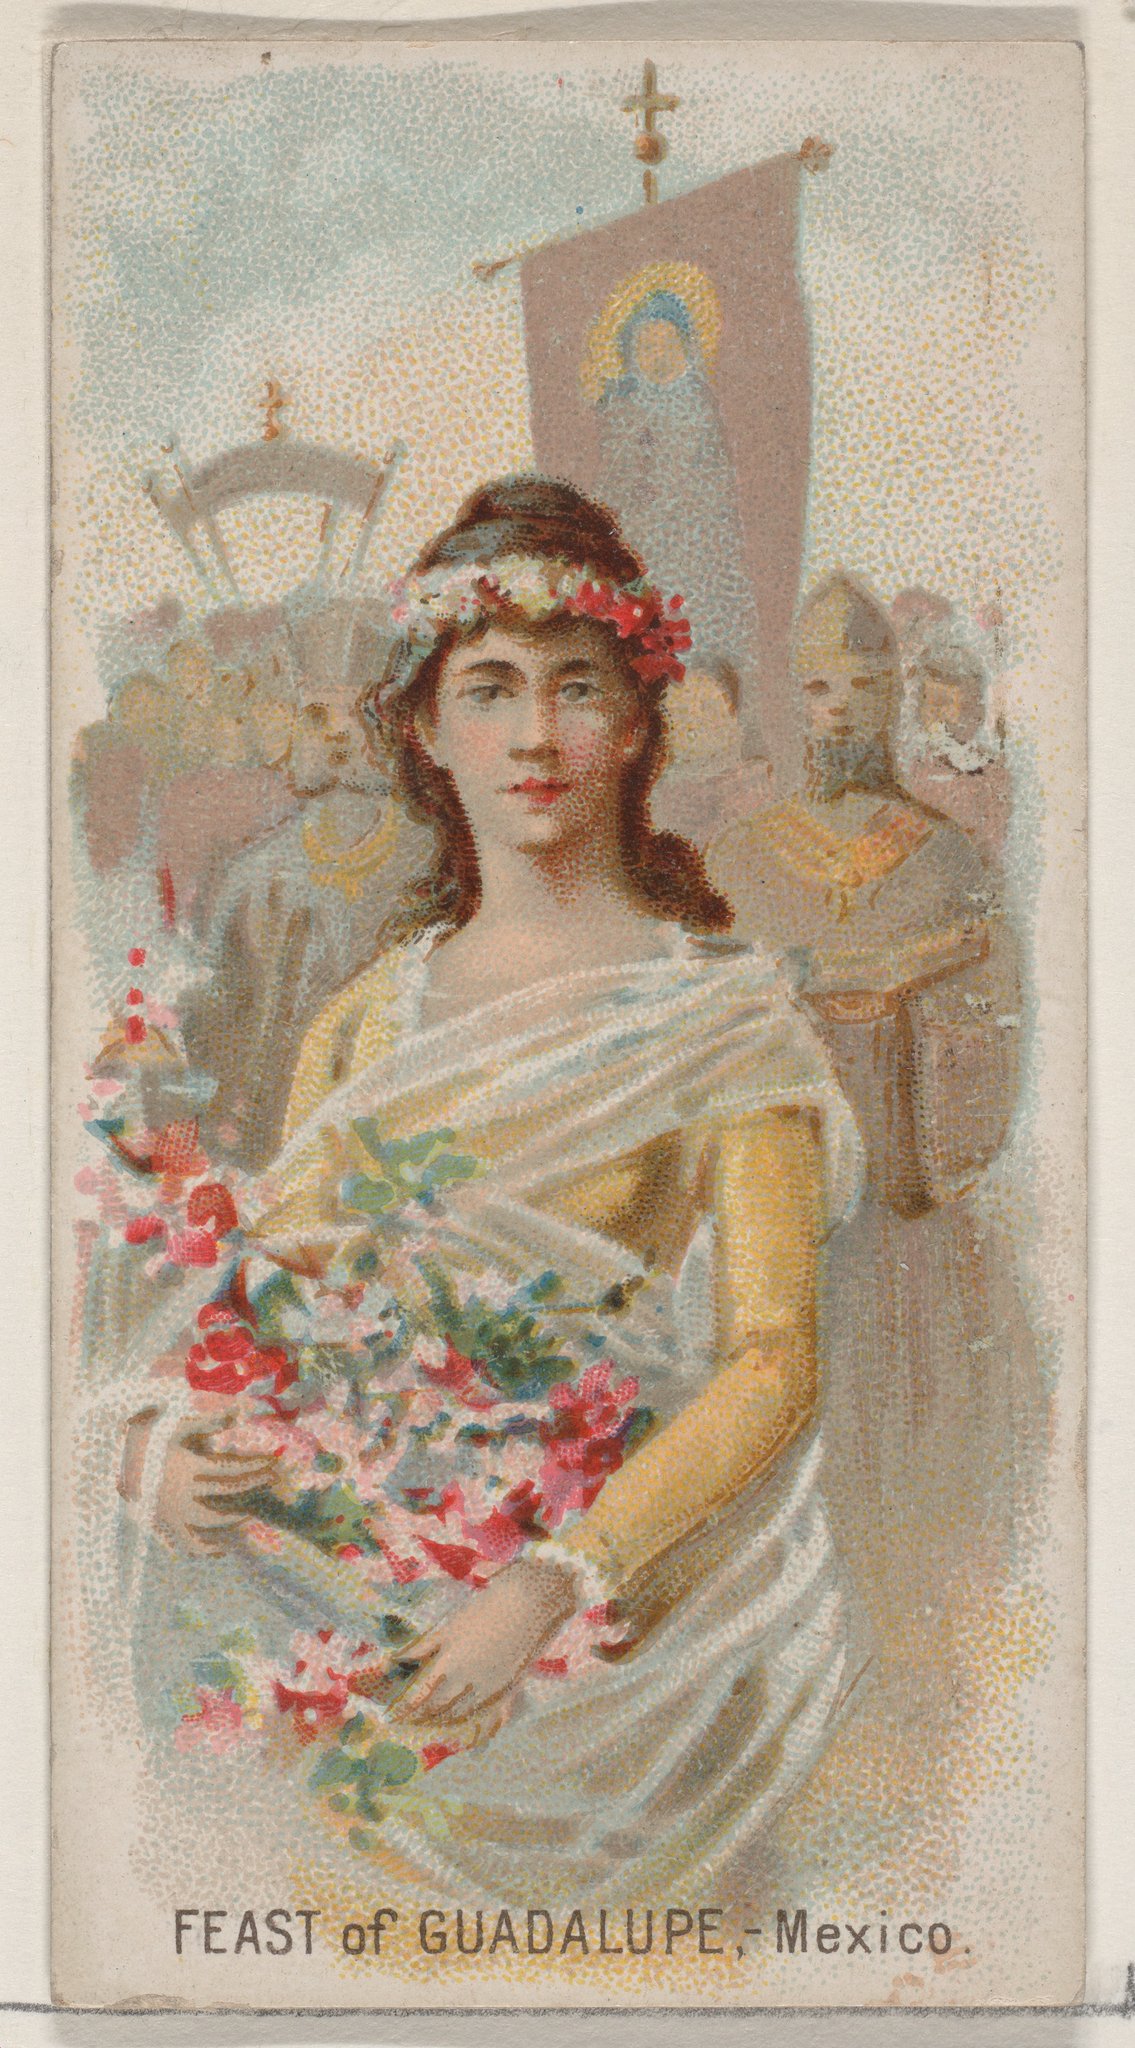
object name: print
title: Feast of Guadalupe, Mexico, from the Holidays series (N80) for Duke brand cigarettes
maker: w. duke, sons & co.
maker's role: publisher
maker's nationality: american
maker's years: 1870-1920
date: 1890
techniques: color lithograph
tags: women